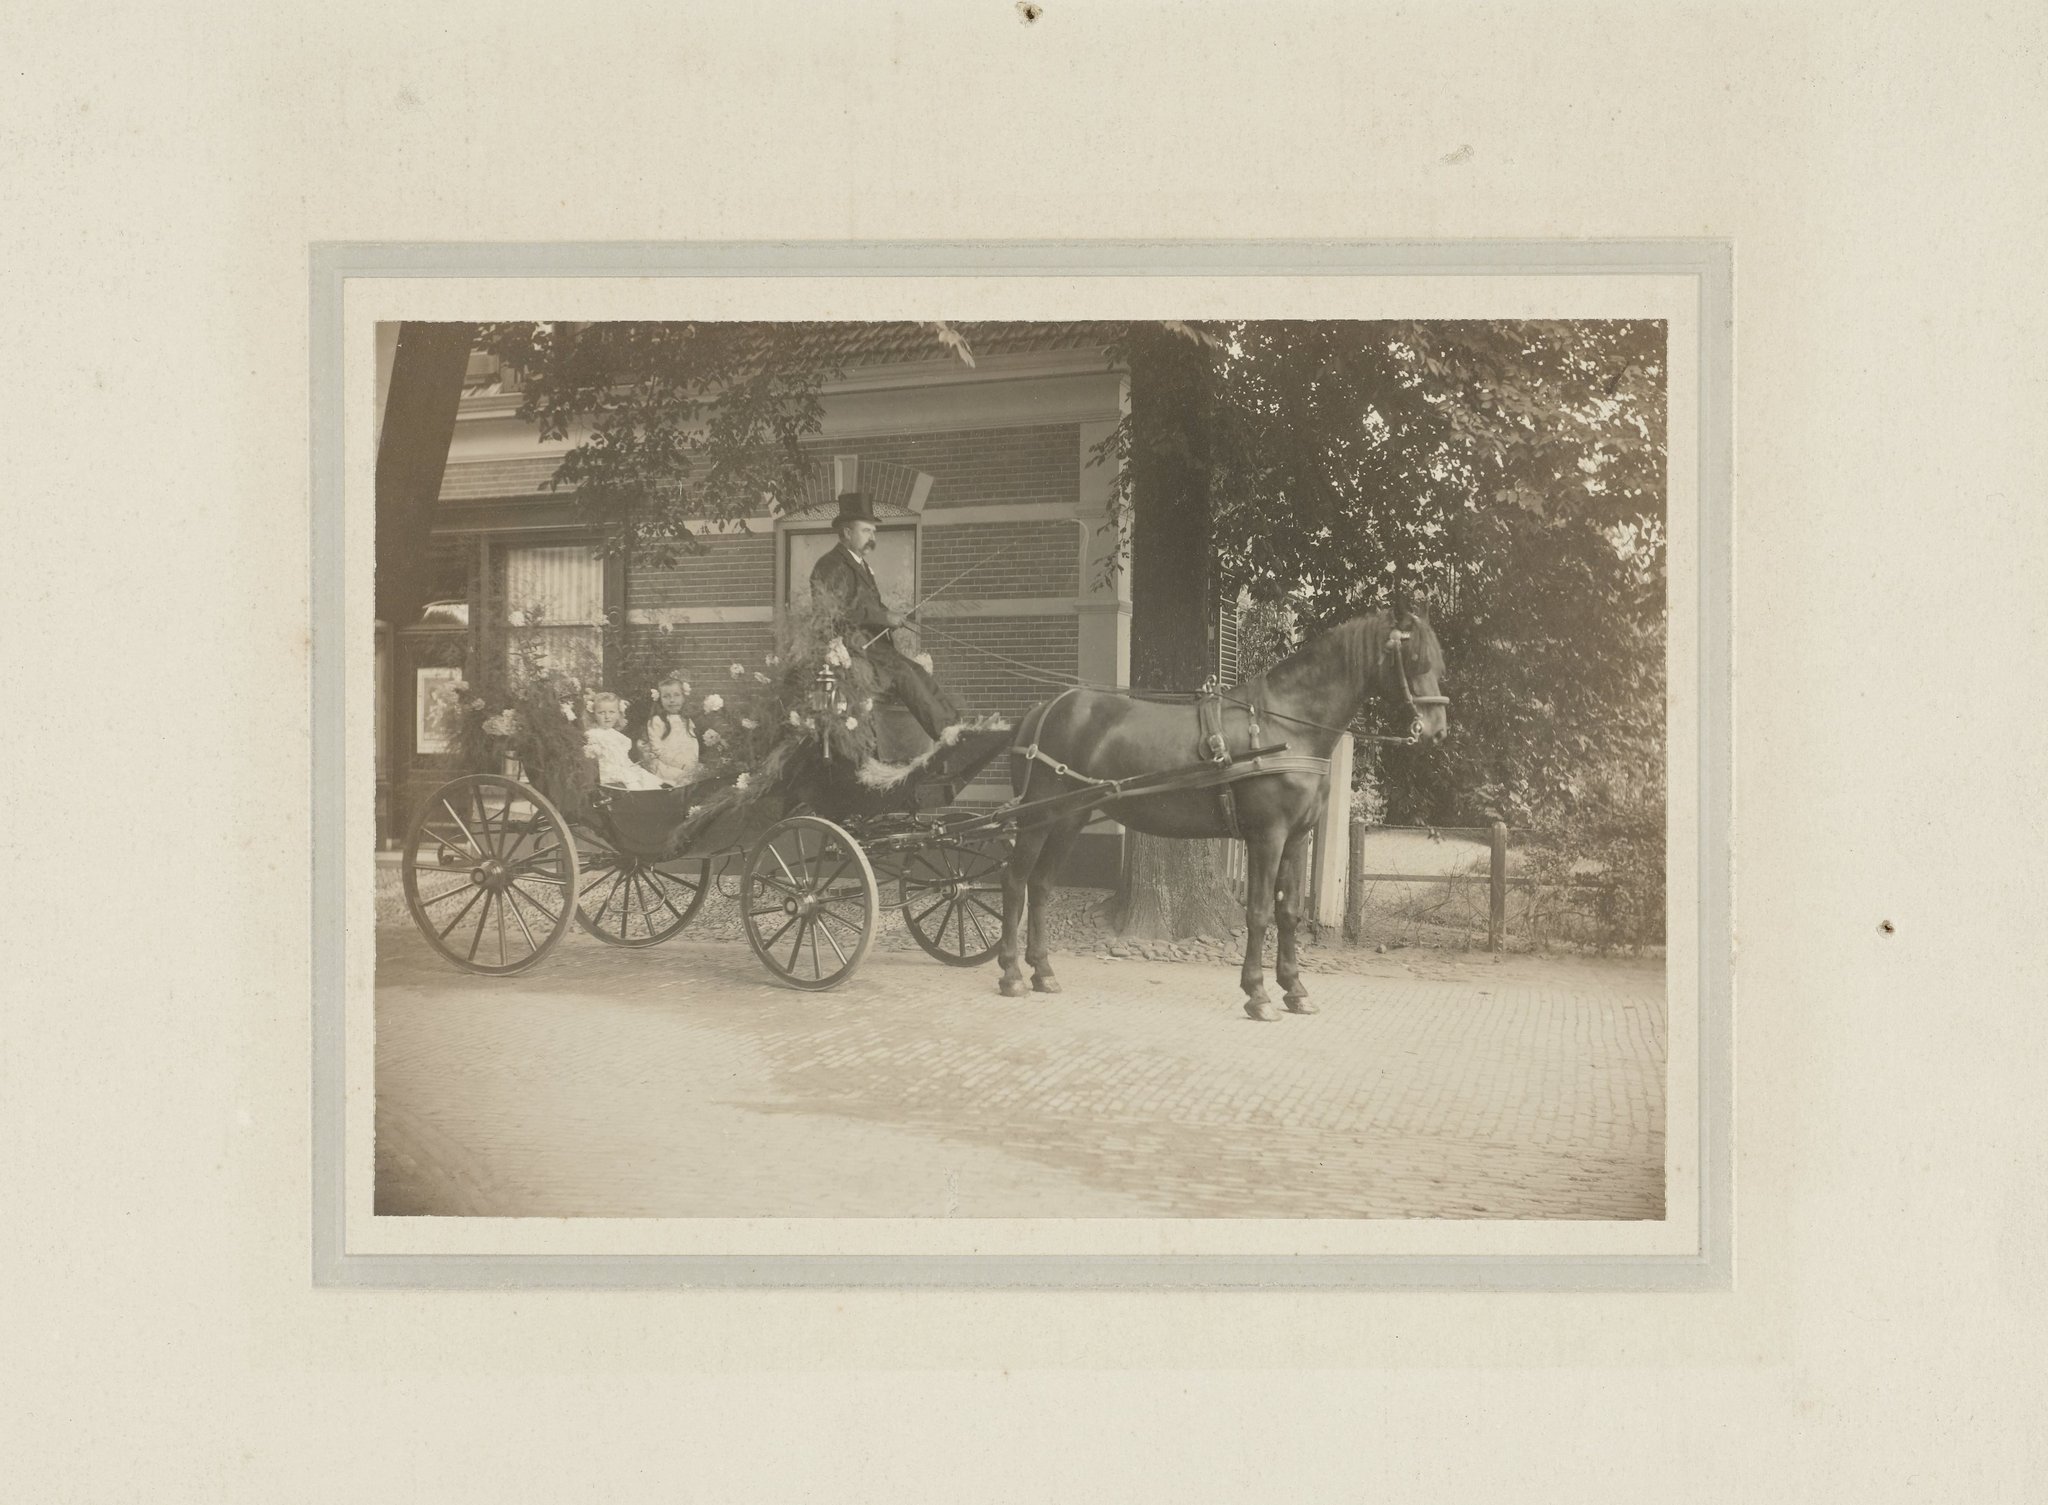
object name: photograph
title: Twee meisjes in een versierd rijtuig met een koetsier getrokken door een paard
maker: Anonymous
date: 1890-1910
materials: paper, cardboard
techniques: gelatin silver print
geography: netherlands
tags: four-wheeled vehicle drawn by one animal, girl (child between toddler and youth) (+ two persons)